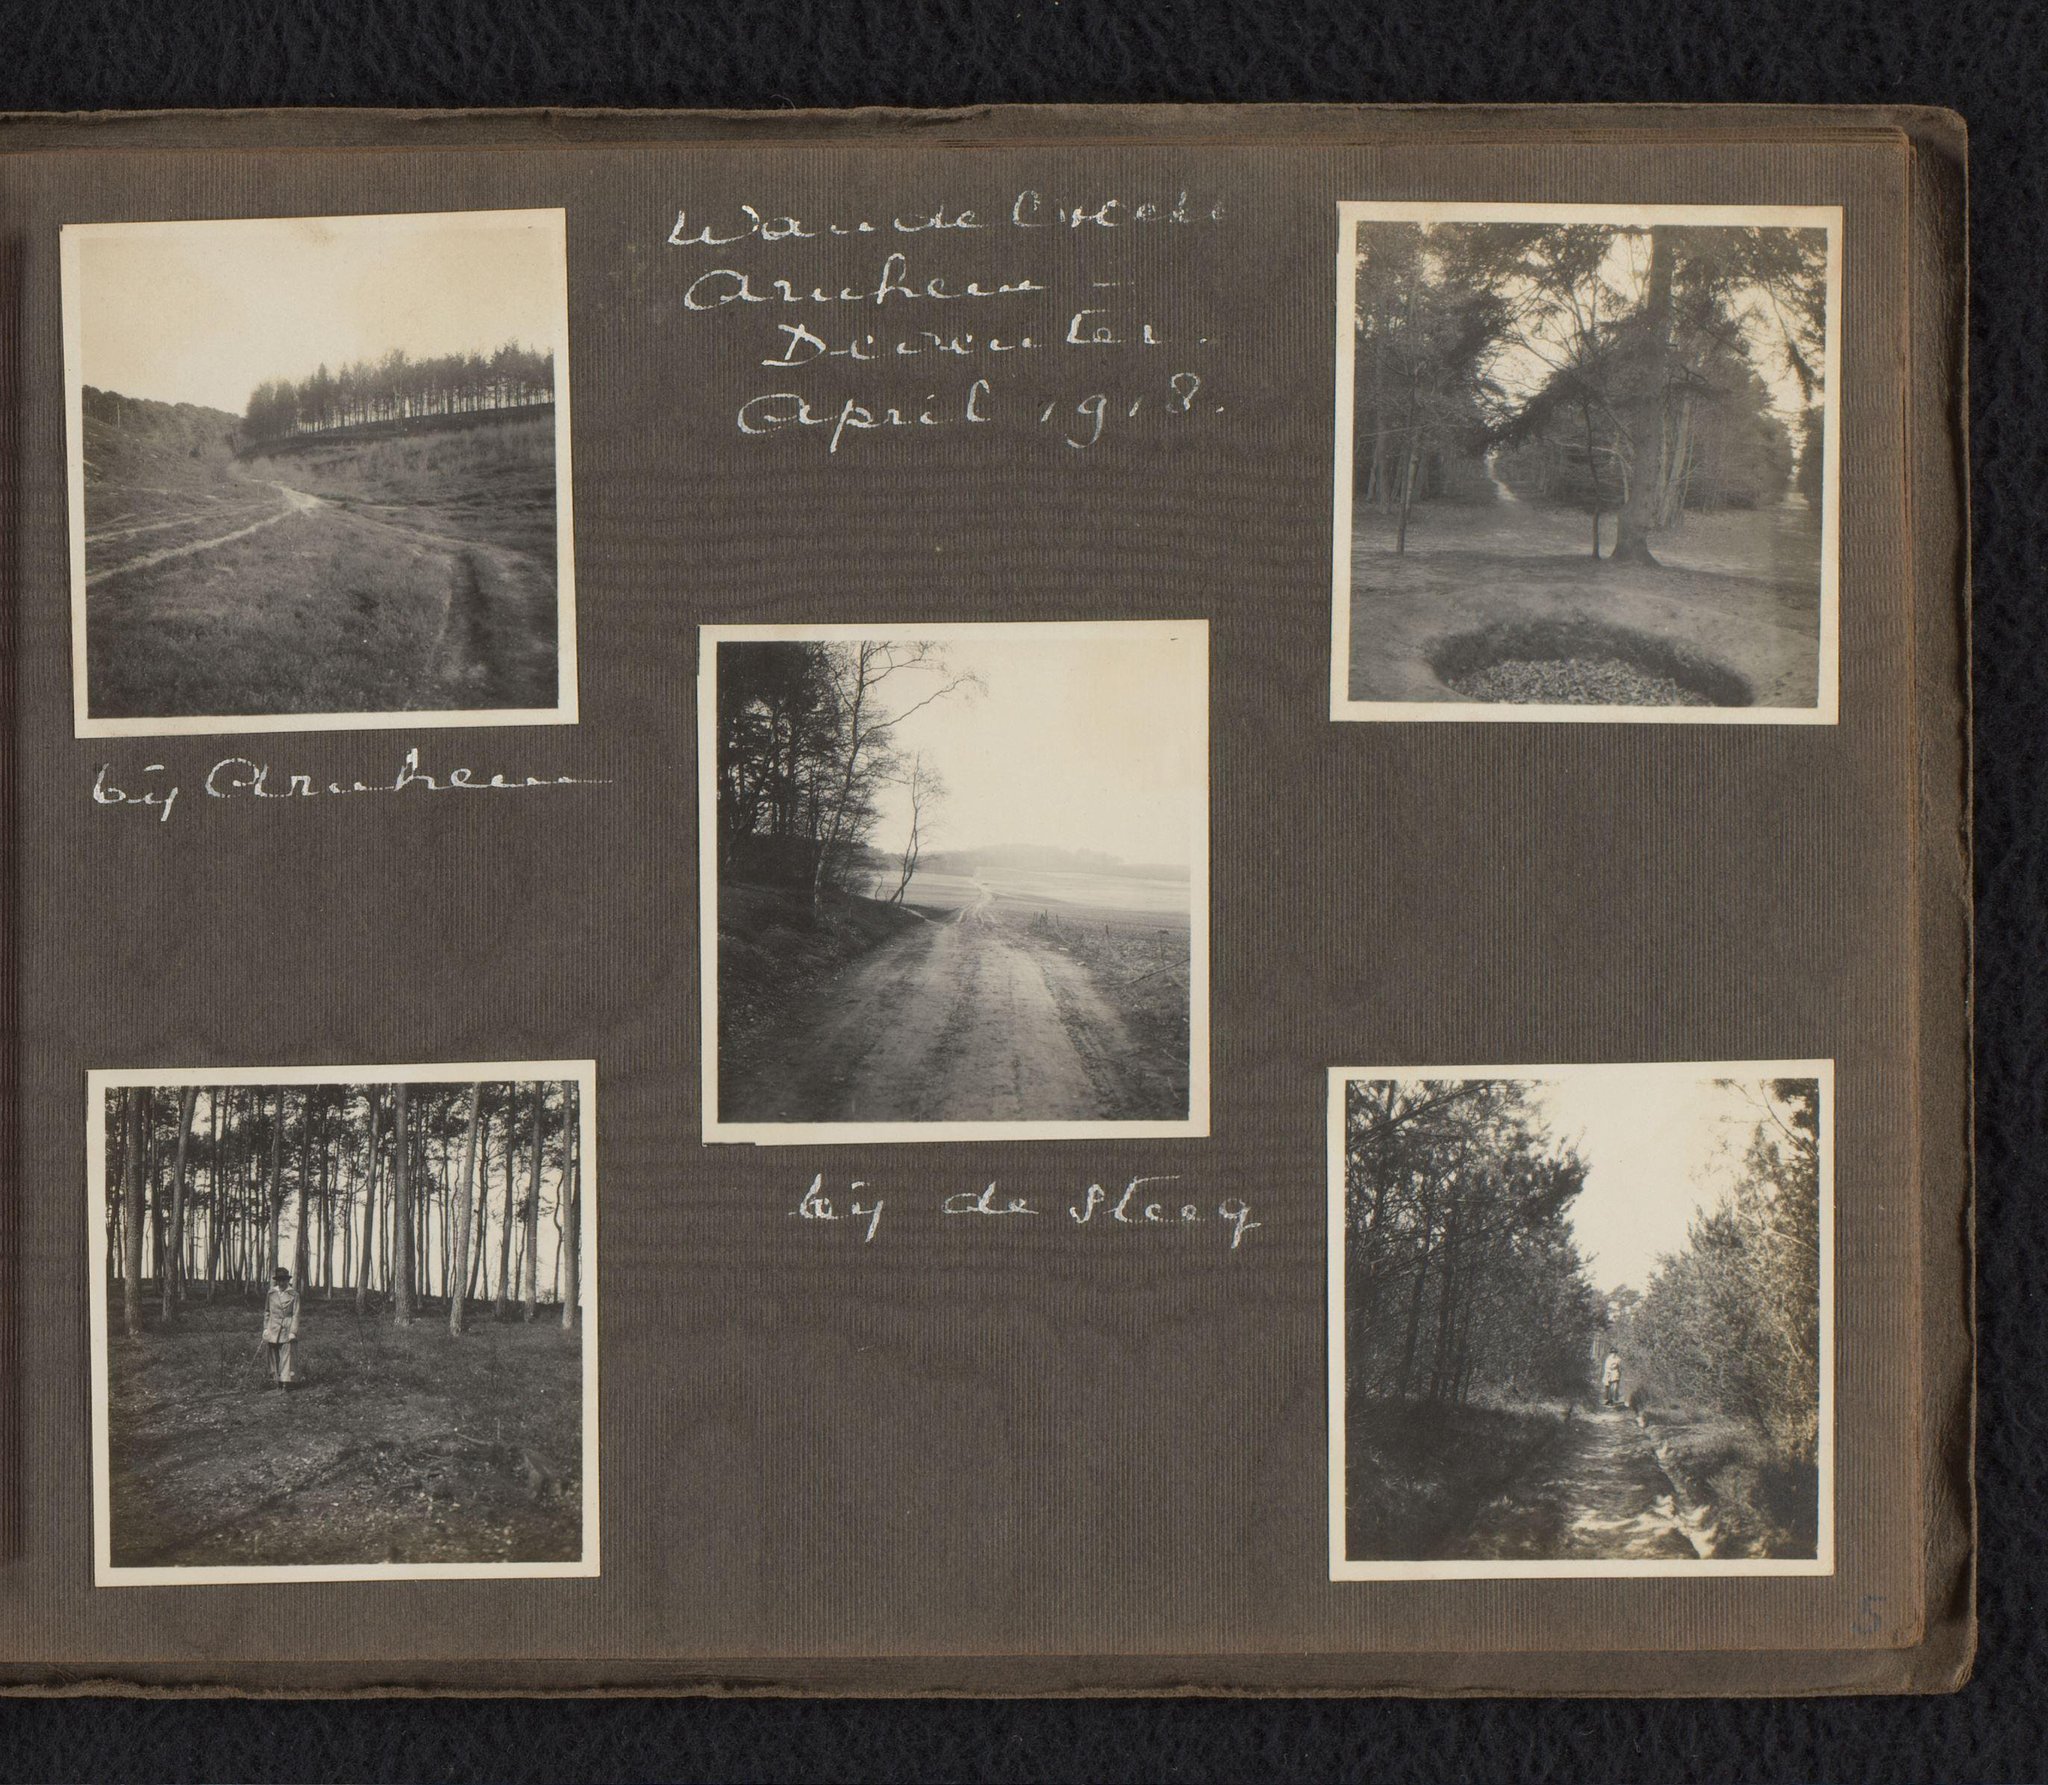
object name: photograph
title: Vijf foto's van familie Onnen-Van den Berg tijdens wandelingen bij Arnhem en De Steeg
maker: Anonymous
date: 1904-1917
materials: paper, cardboard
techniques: gelatin silver print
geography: gelderland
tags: walking, hiking (recreation), fringe, edge of the wood, family life, forest path or lane, arnhem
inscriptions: caption: ‘Wandelingen/ Arnhem/ Deventer/ April 1918/ bij Arnhem/ bij de Steeg’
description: Deze foto's maken deel uit van een album.